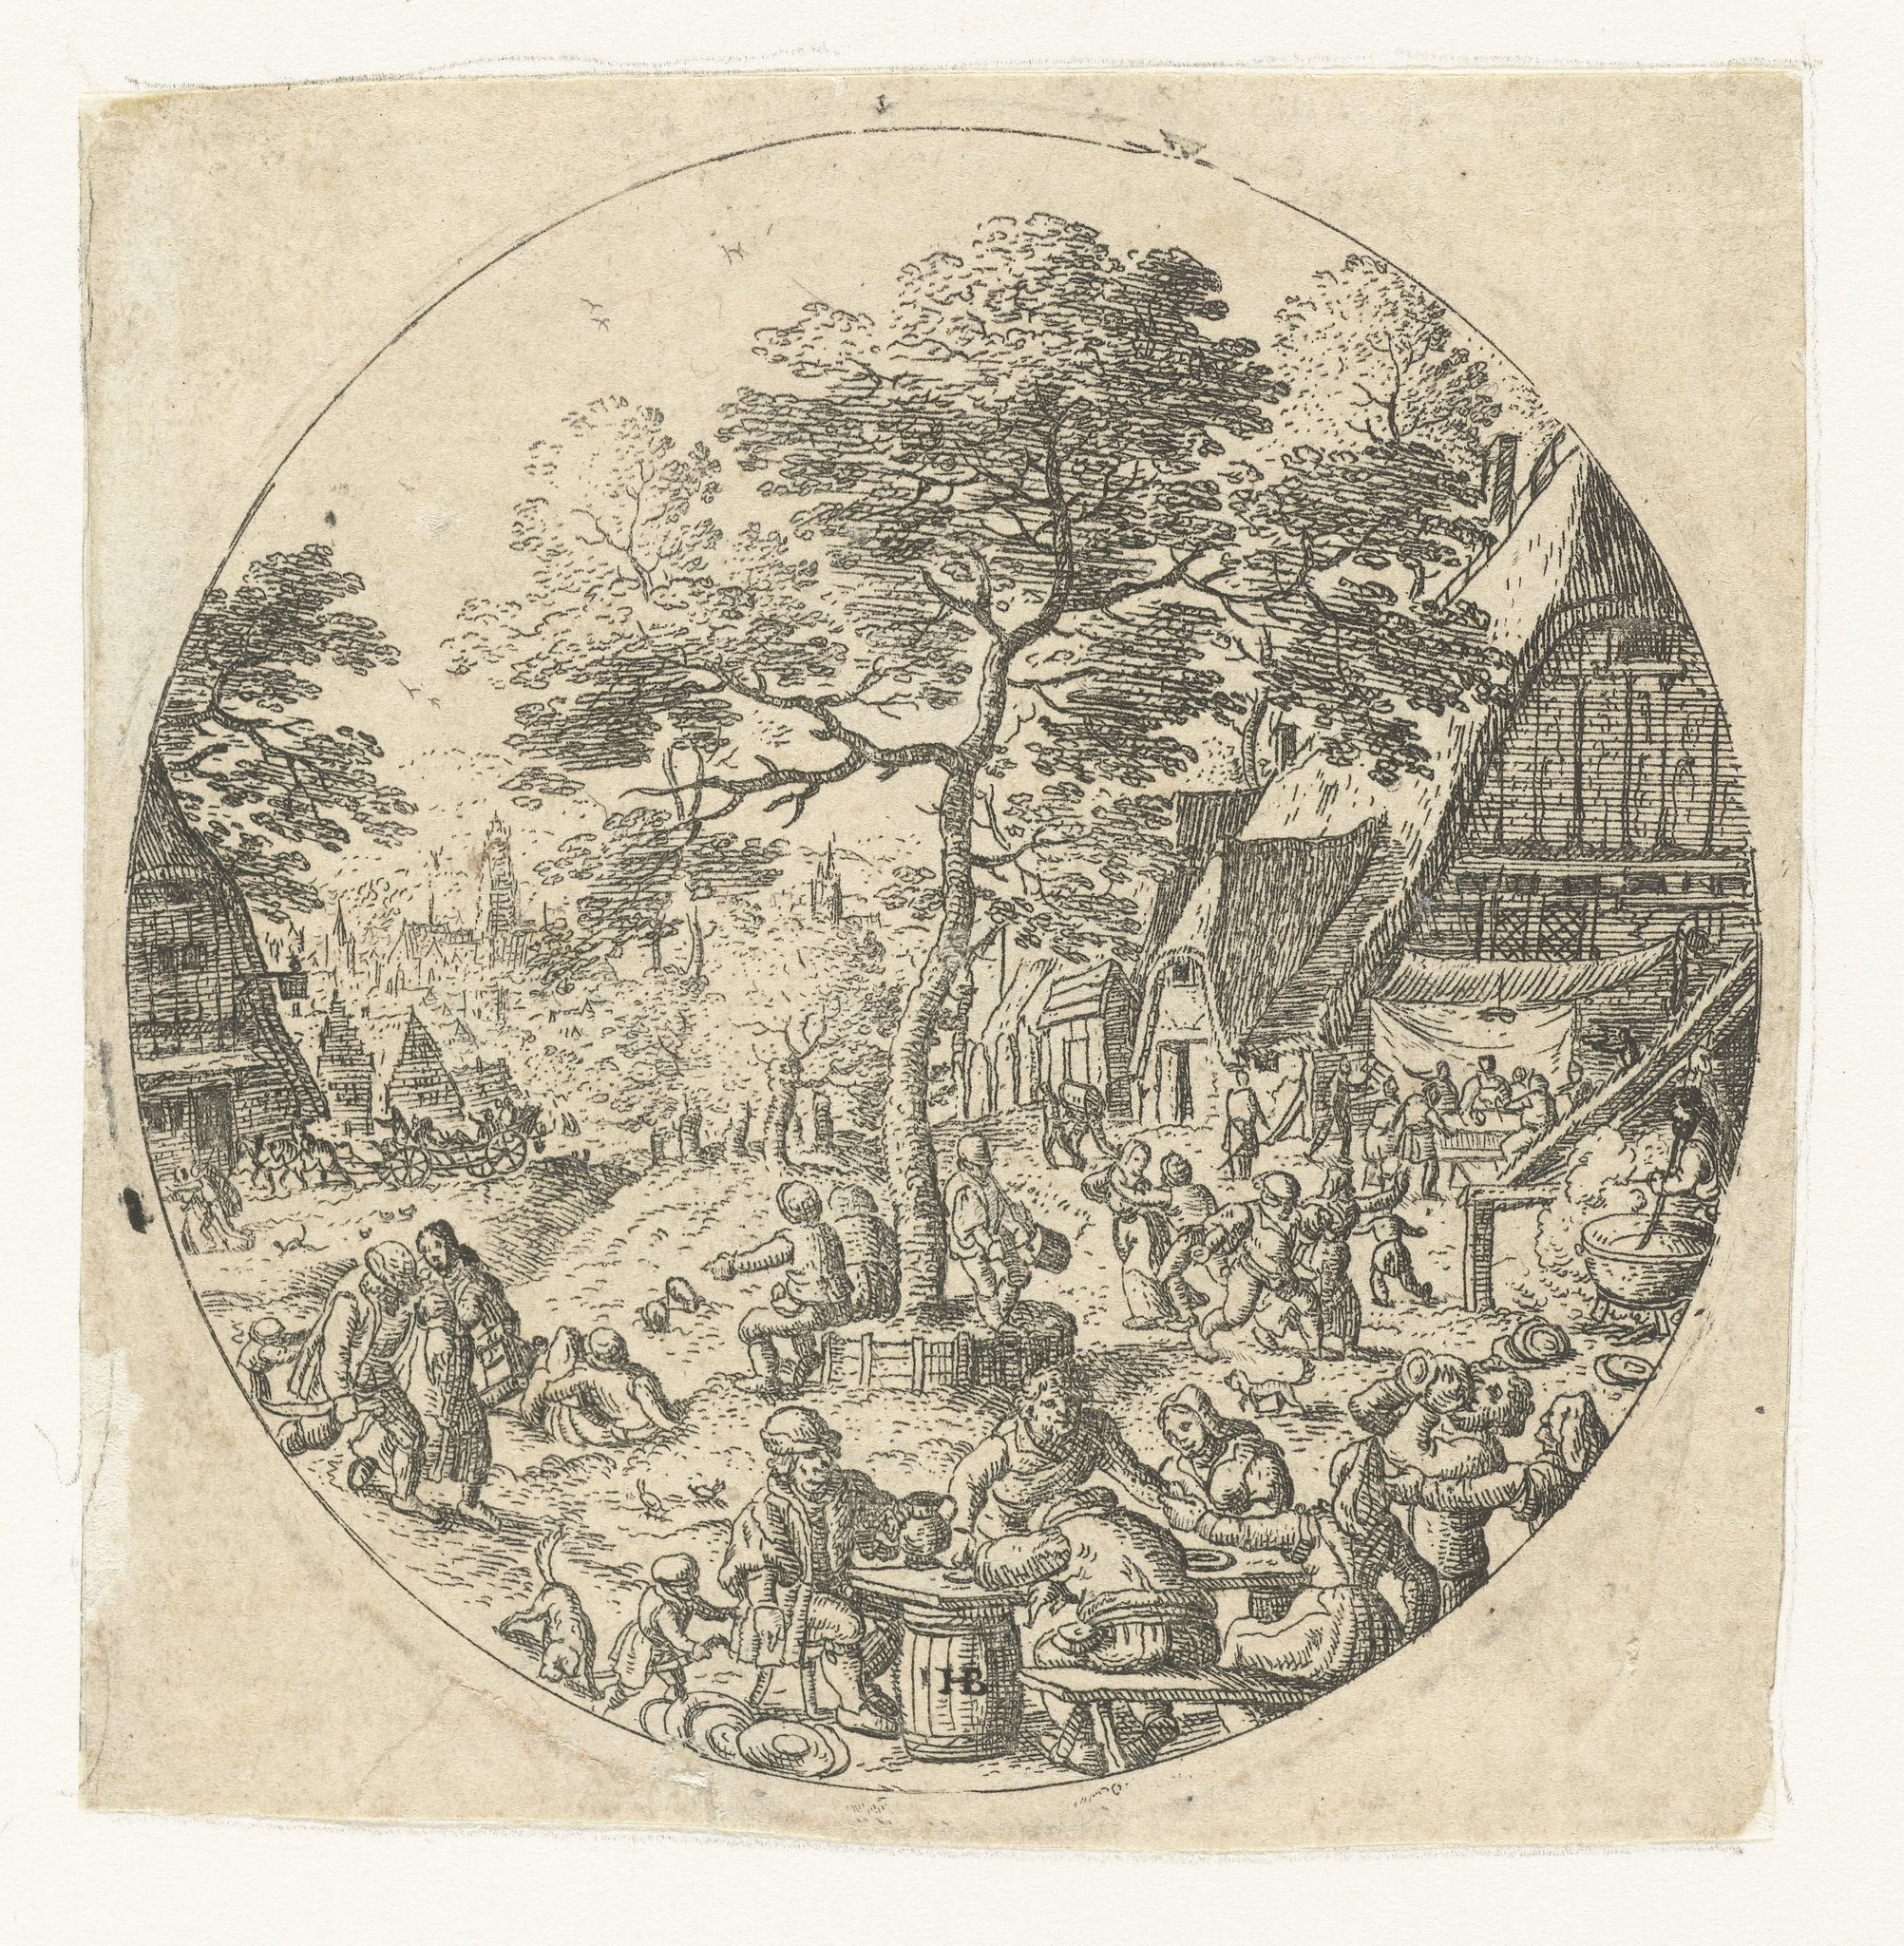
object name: print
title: Boerenfeest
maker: hans bol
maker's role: draughtsman, print maker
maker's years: 1534-1593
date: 1550-1593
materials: paper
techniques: etching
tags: festivities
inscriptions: collector's mark: Lugt 318, collector's mark: Lugt 2228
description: Op het dorpsplein vindt een feest plaats. Boeren dansen en vrijen, er wordt gekookt en gegeten. Op de voorgrond staat een tafel van twee vaten met een plank erop. In het midden van het plein staat een boom. Onder de boom zitten twee mannen.